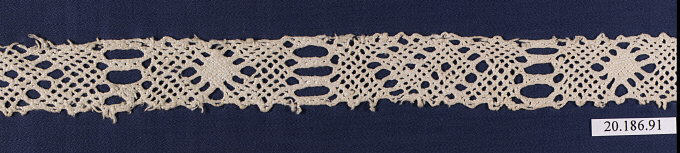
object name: insertion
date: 1501-1600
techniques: lace